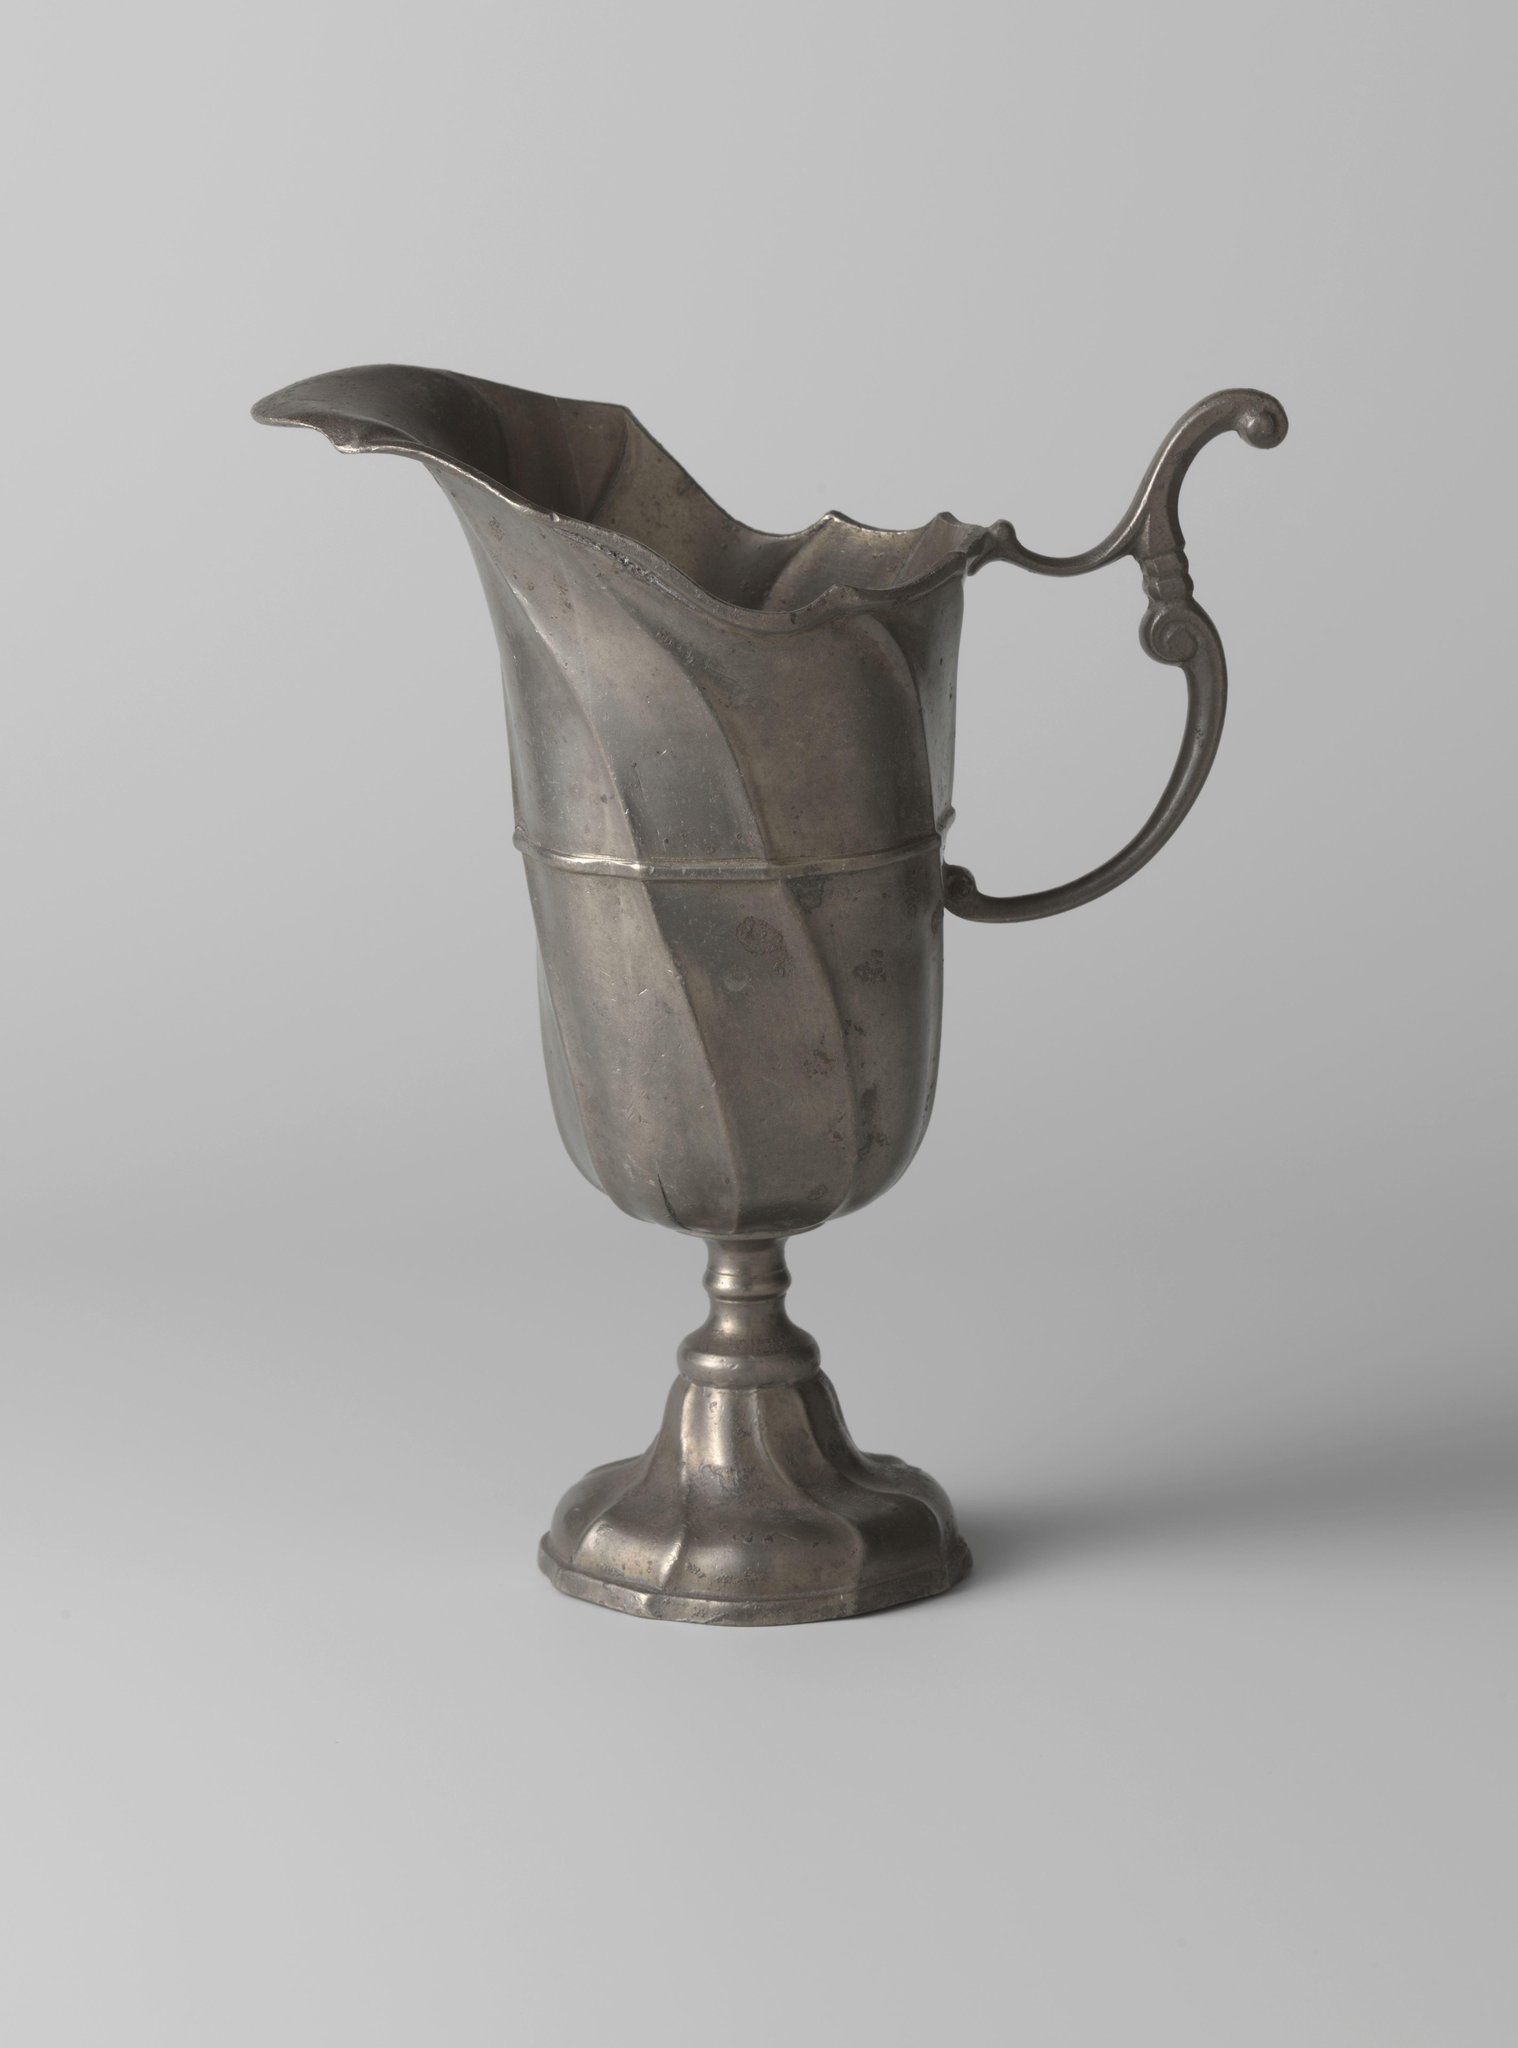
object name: ewer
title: Kan, getordeerd model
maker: Anonymous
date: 1700-1800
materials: tin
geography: great britain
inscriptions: quality mark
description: Kan van tin, getordeerd model. De voet loopt naar boven smal toe tot aan de kan. Halverwege de kan bevindt zich een horizontale band. De bovenrand is licht geschulpt en loopt uit in een brede. hoge schenktuit. Het aangezette handvat in de vorm van twee krullen loopt van net onder de horizontale band tot aan de opening aan de bovenzijde van de kan.